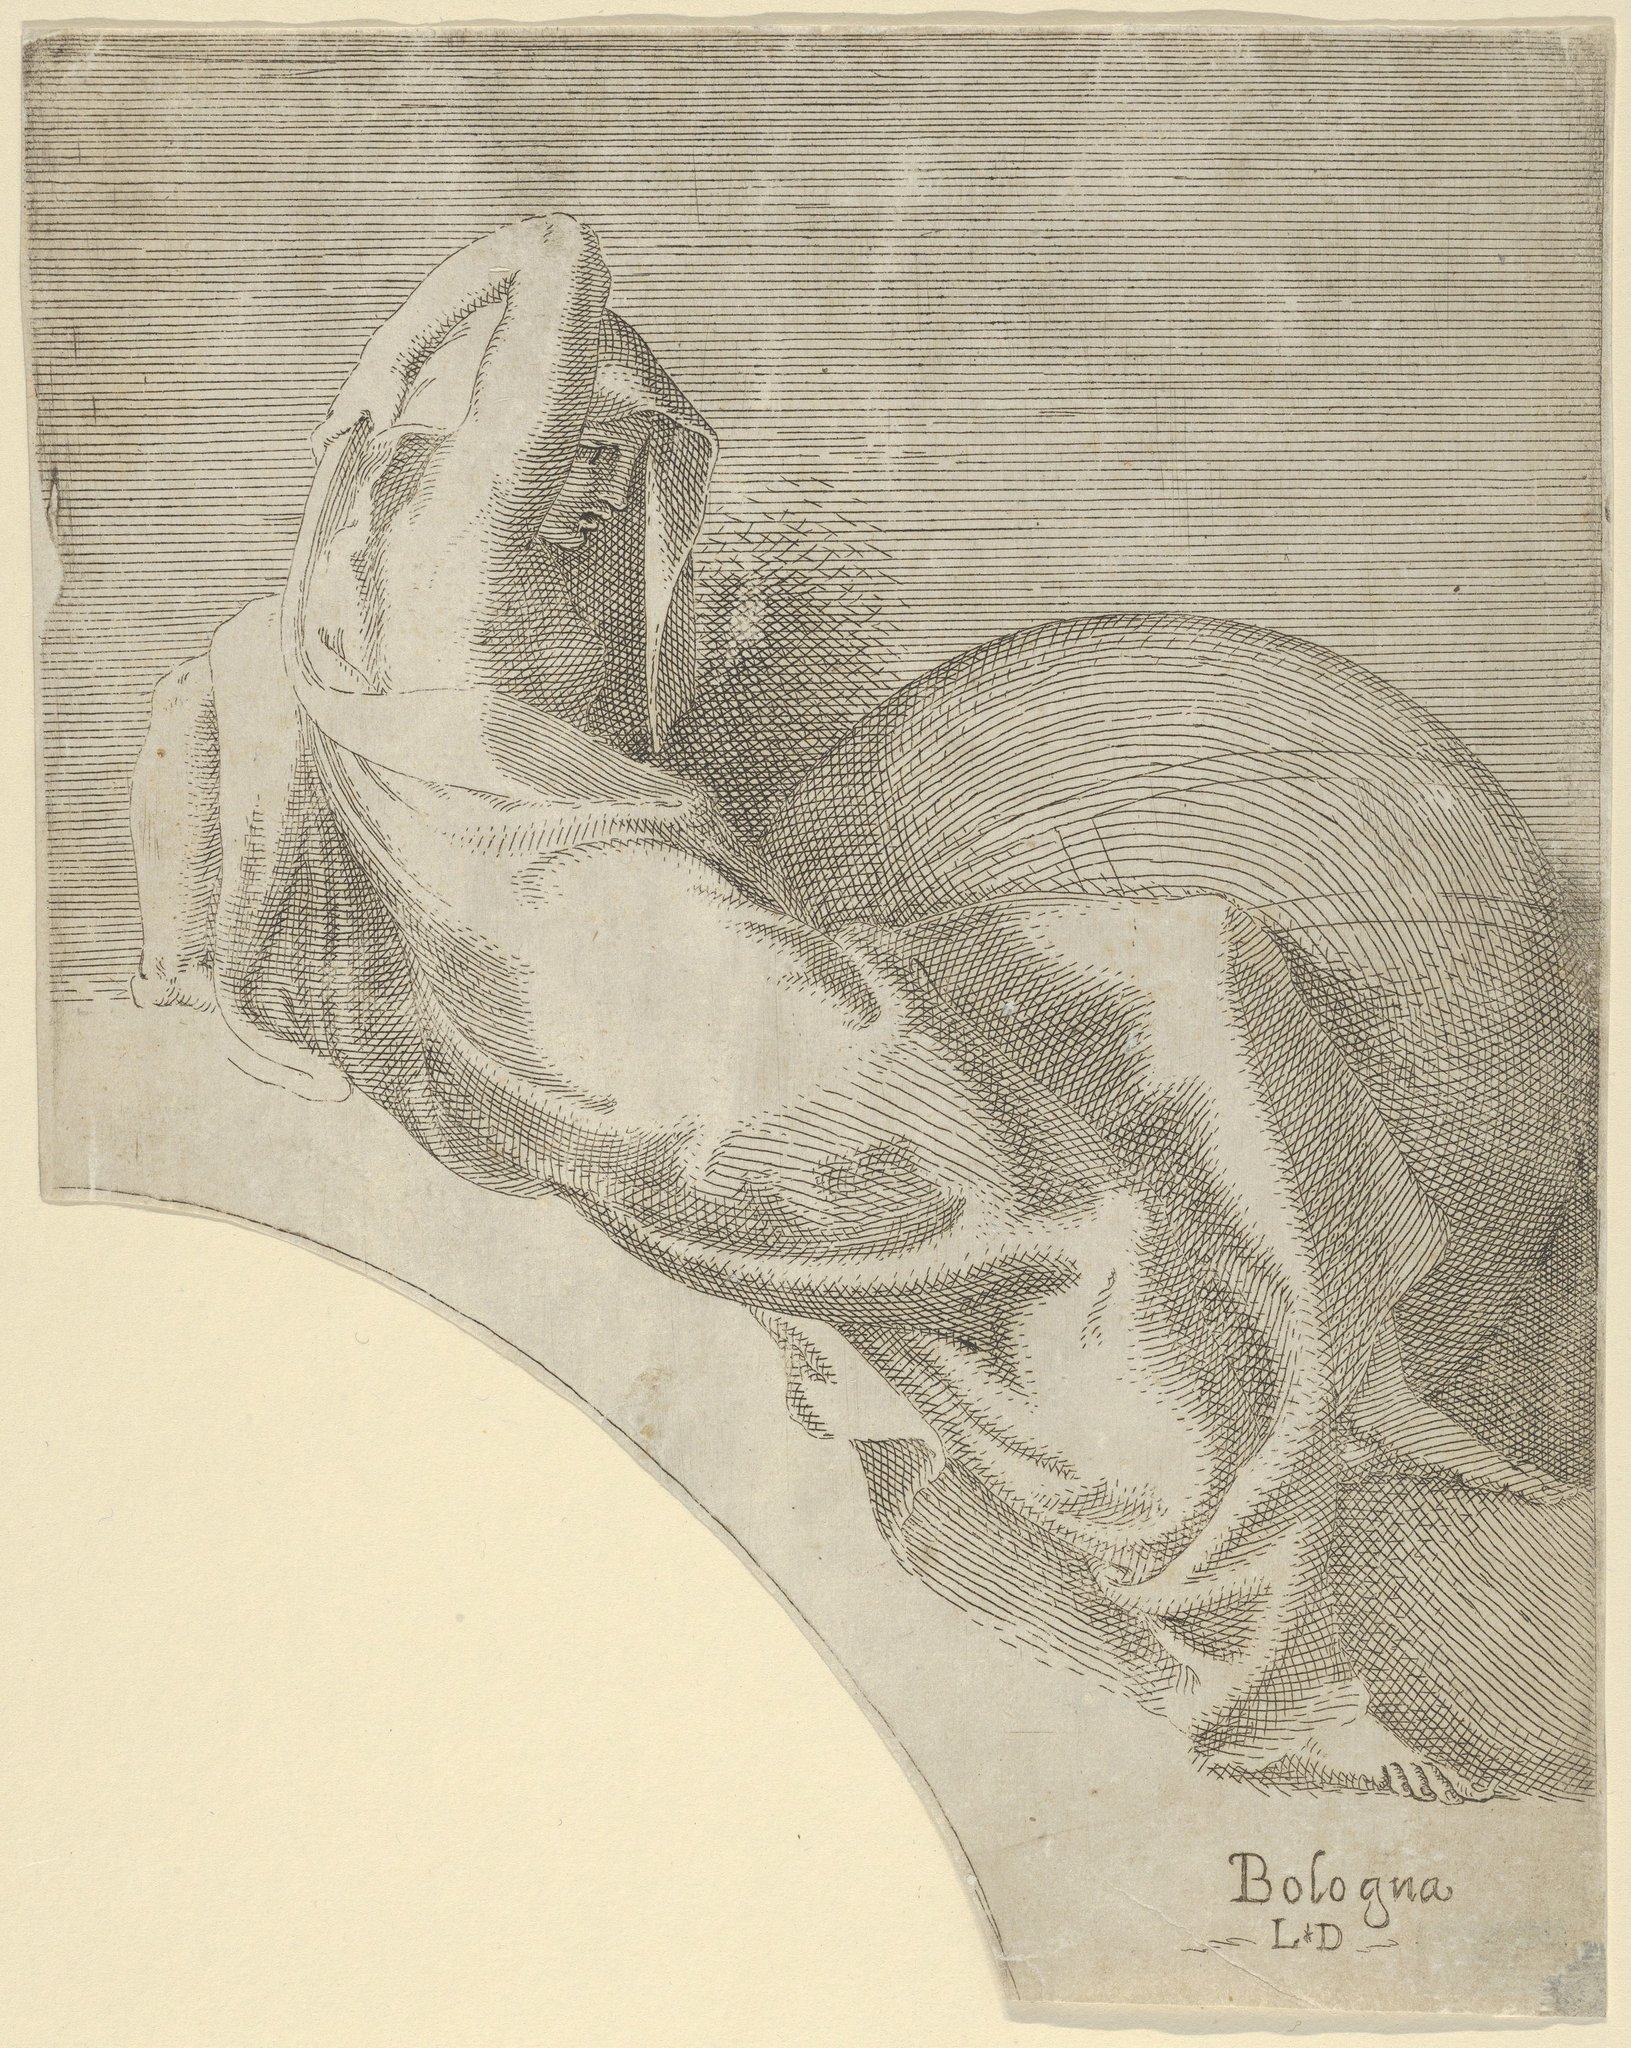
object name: print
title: Urania, from "Twelve Muses and Goddesses"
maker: léon davent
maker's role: artist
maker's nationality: french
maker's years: 1540-1556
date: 1542-1545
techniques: etching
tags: muses